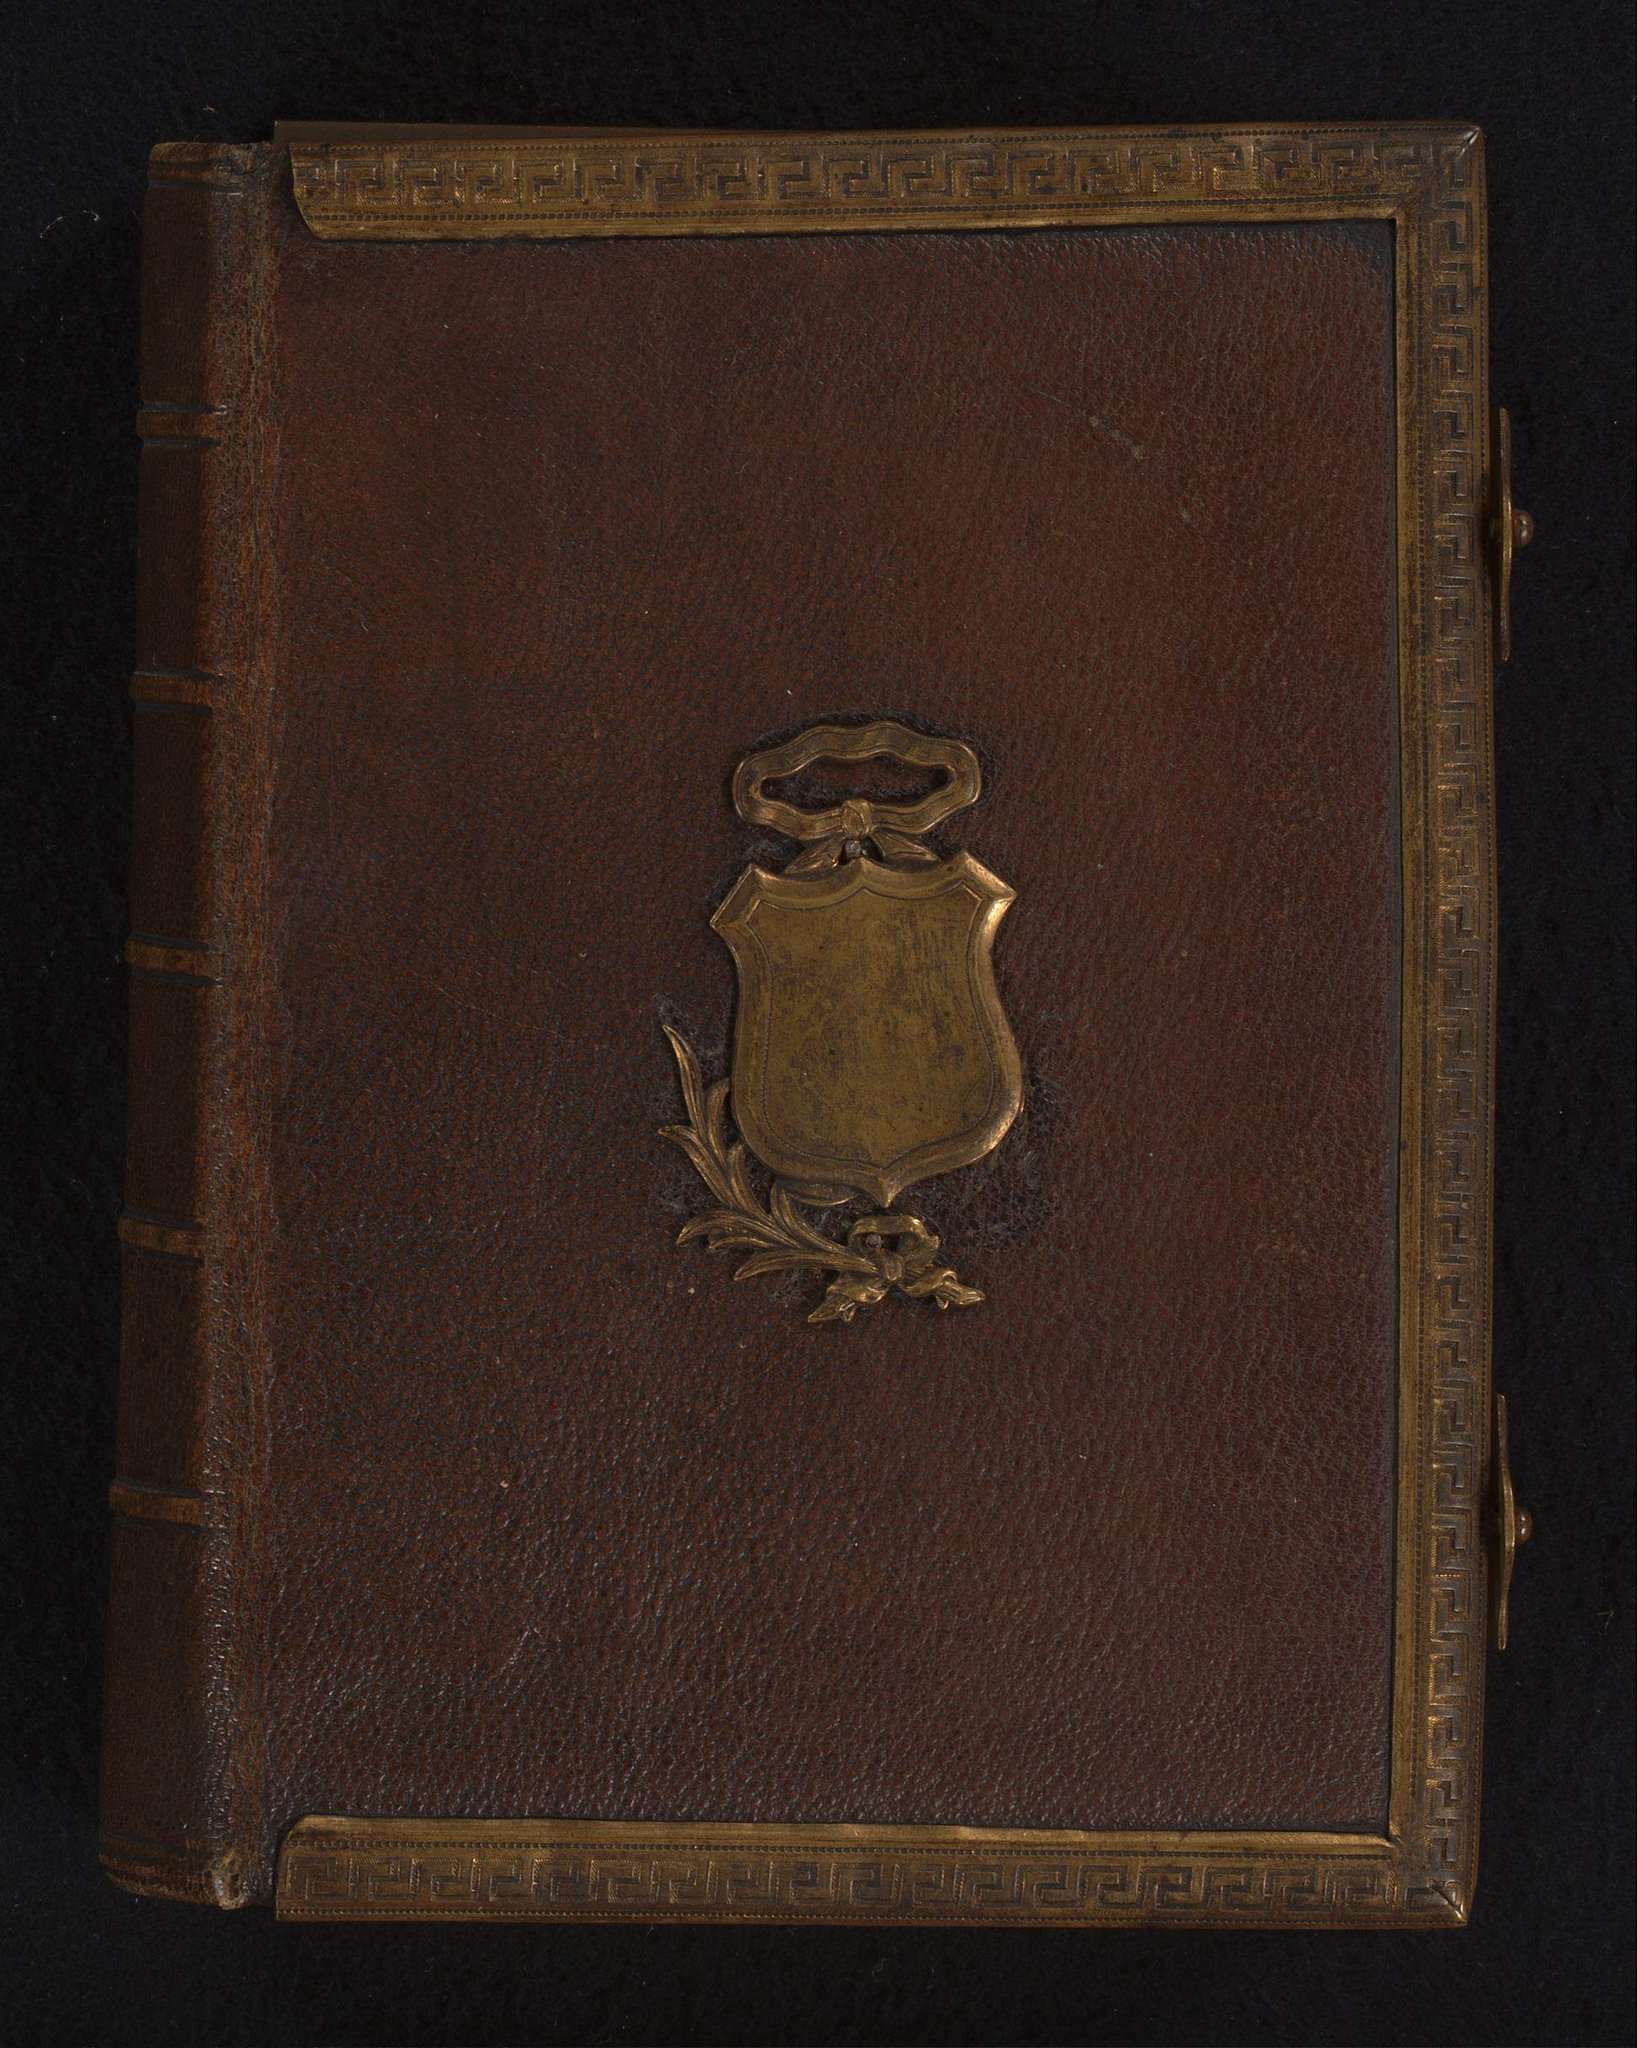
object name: slip in album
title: Fotoalbum (leeg)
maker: Anonymous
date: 1860-1900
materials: cardboard, copper, leather, paper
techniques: color on snow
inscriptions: collector's mark: ‘DIENST/ VERSPREIDE/ RIJKSKOLLEKTIES/ (...) A 781’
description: Fotoalbum met veertig pagina's met ieder een met gepreegde rand omkaderde passe-partout voor een carte-de-visite.